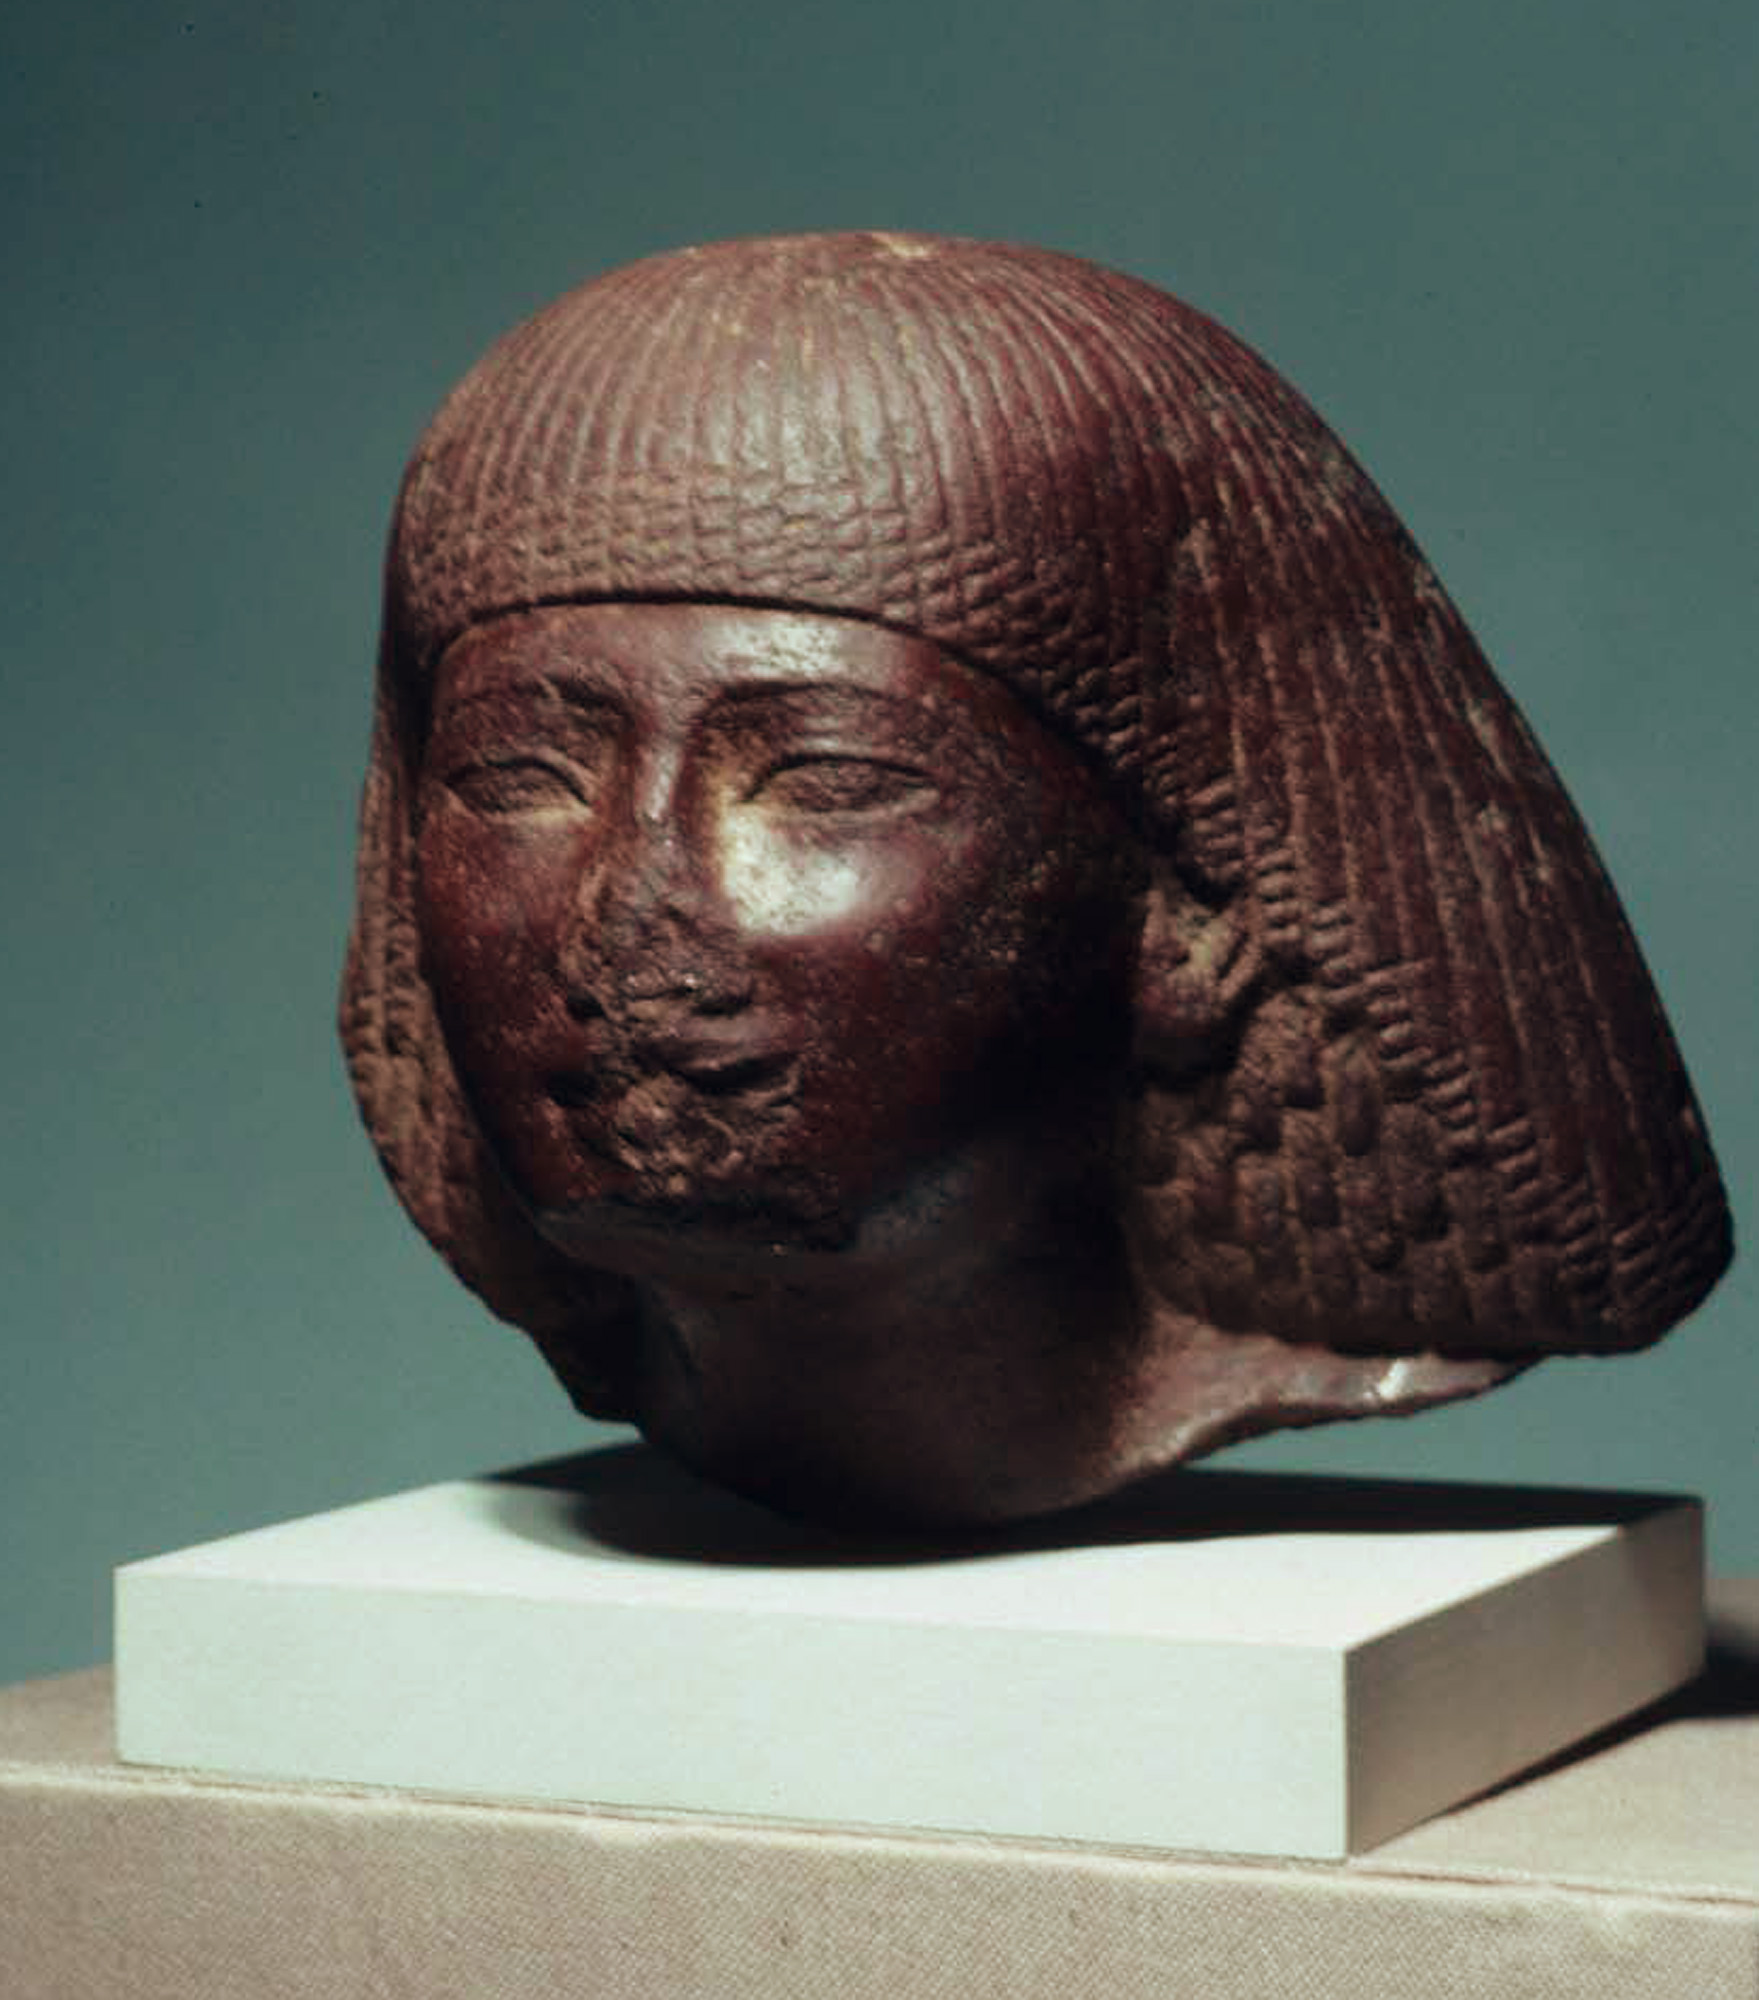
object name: head, man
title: Head of a Man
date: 1390-1352 BCE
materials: quartzite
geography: egypt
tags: heads,men